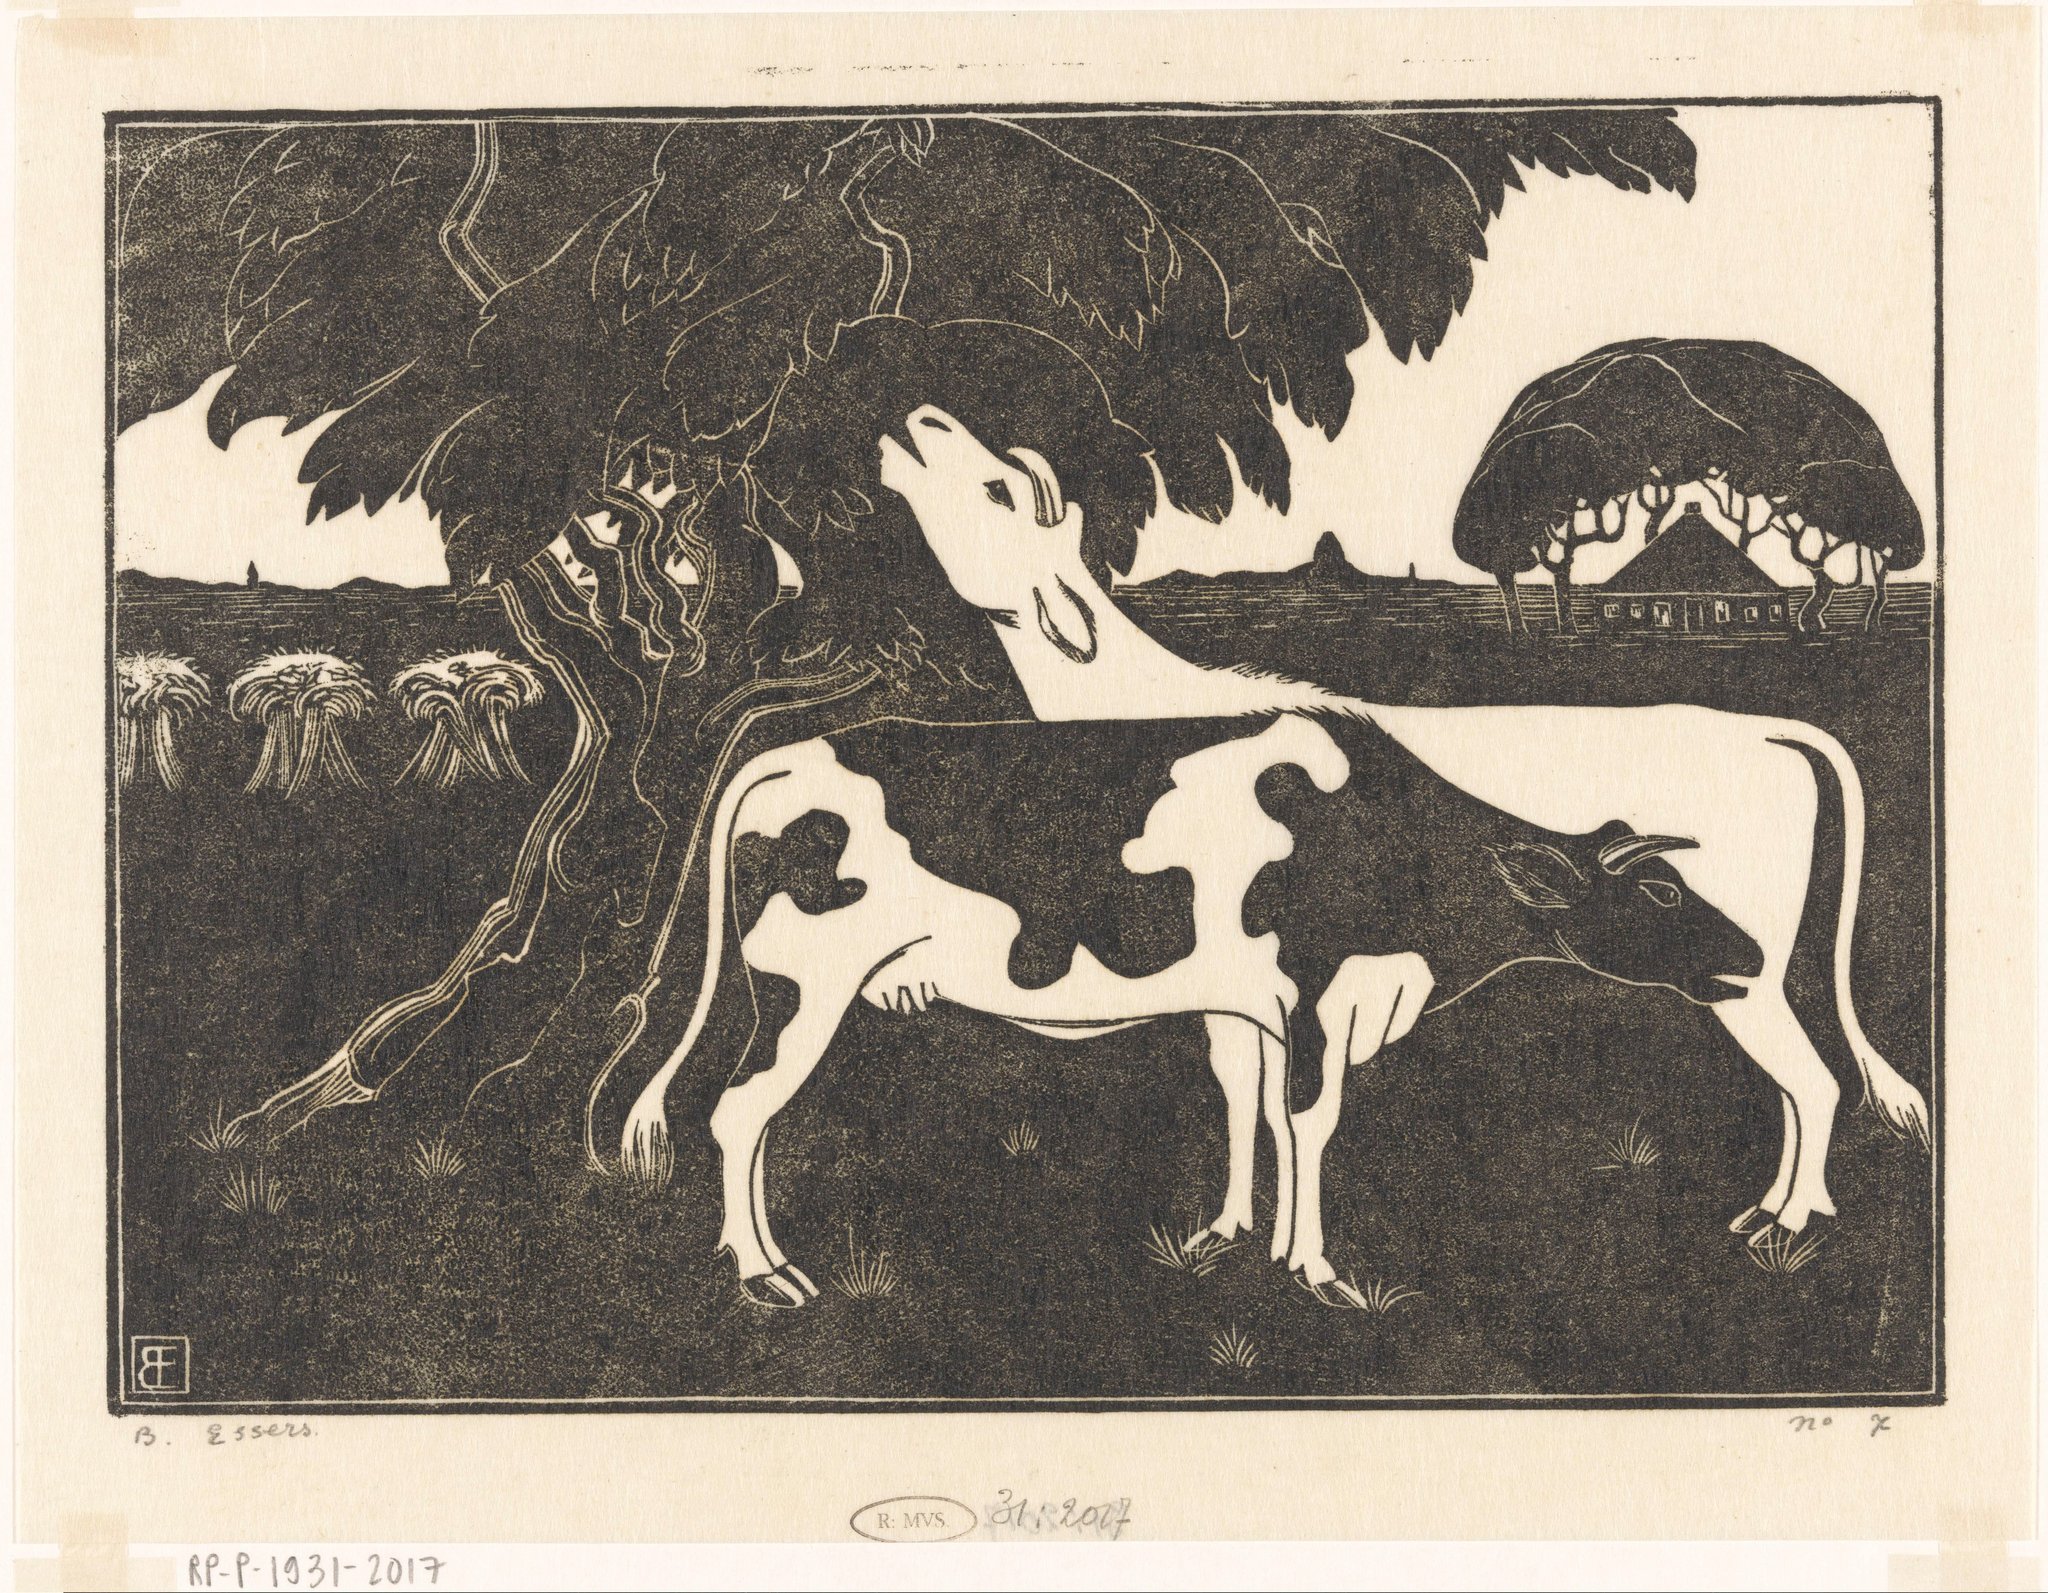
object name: print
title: Twee koeien bij een boom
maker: bernard essers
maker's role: print maker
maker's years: 1893-1945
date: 1925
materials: paper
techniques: engraving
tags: cow, farm or solitary house in landscape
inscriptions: collector's mark: Lugt 2228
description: Links hooischelven. Rechts op de achtergrond een boerderij.